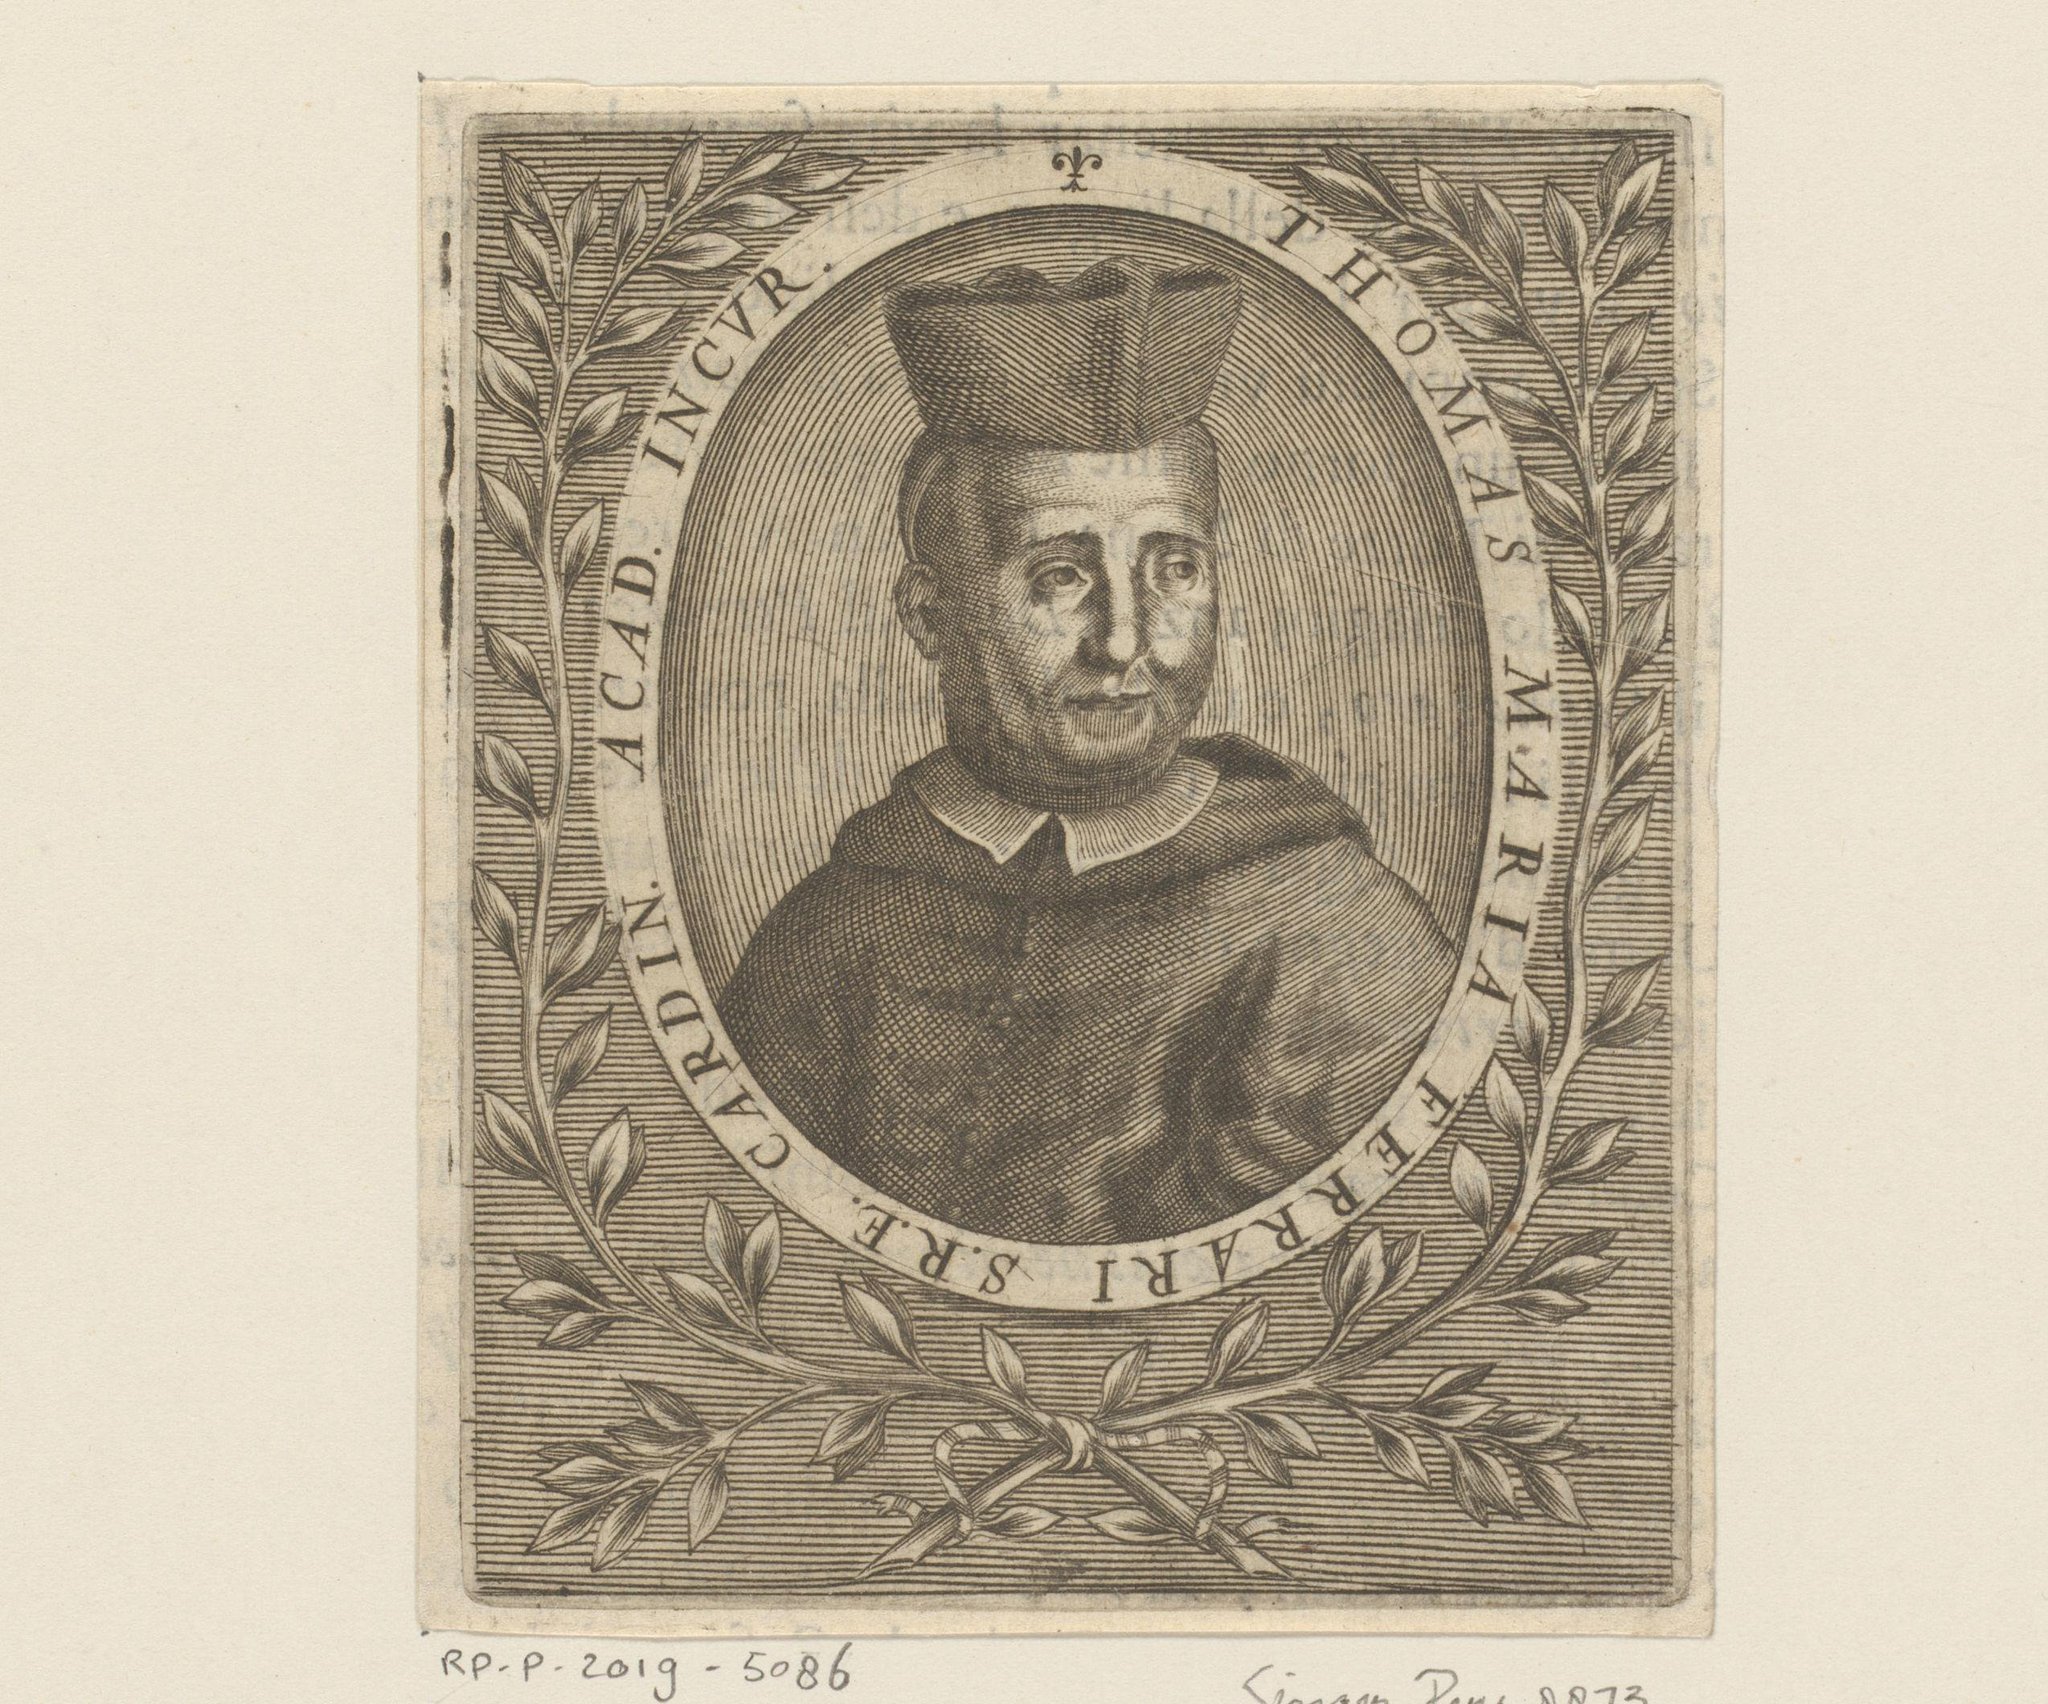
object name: print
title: Portret van kardinaal Tommaso Maria Ferrari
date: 1703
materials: paper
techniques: engraving, etching, letterpress printing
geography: naples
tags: rome, cardinal, historical persons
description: Prent uit: Gimma, Giacinto. Elogj accademici della Società degli Spensierati di Rossano (...). Napels: Carlo Troise, 1703, p. 269.